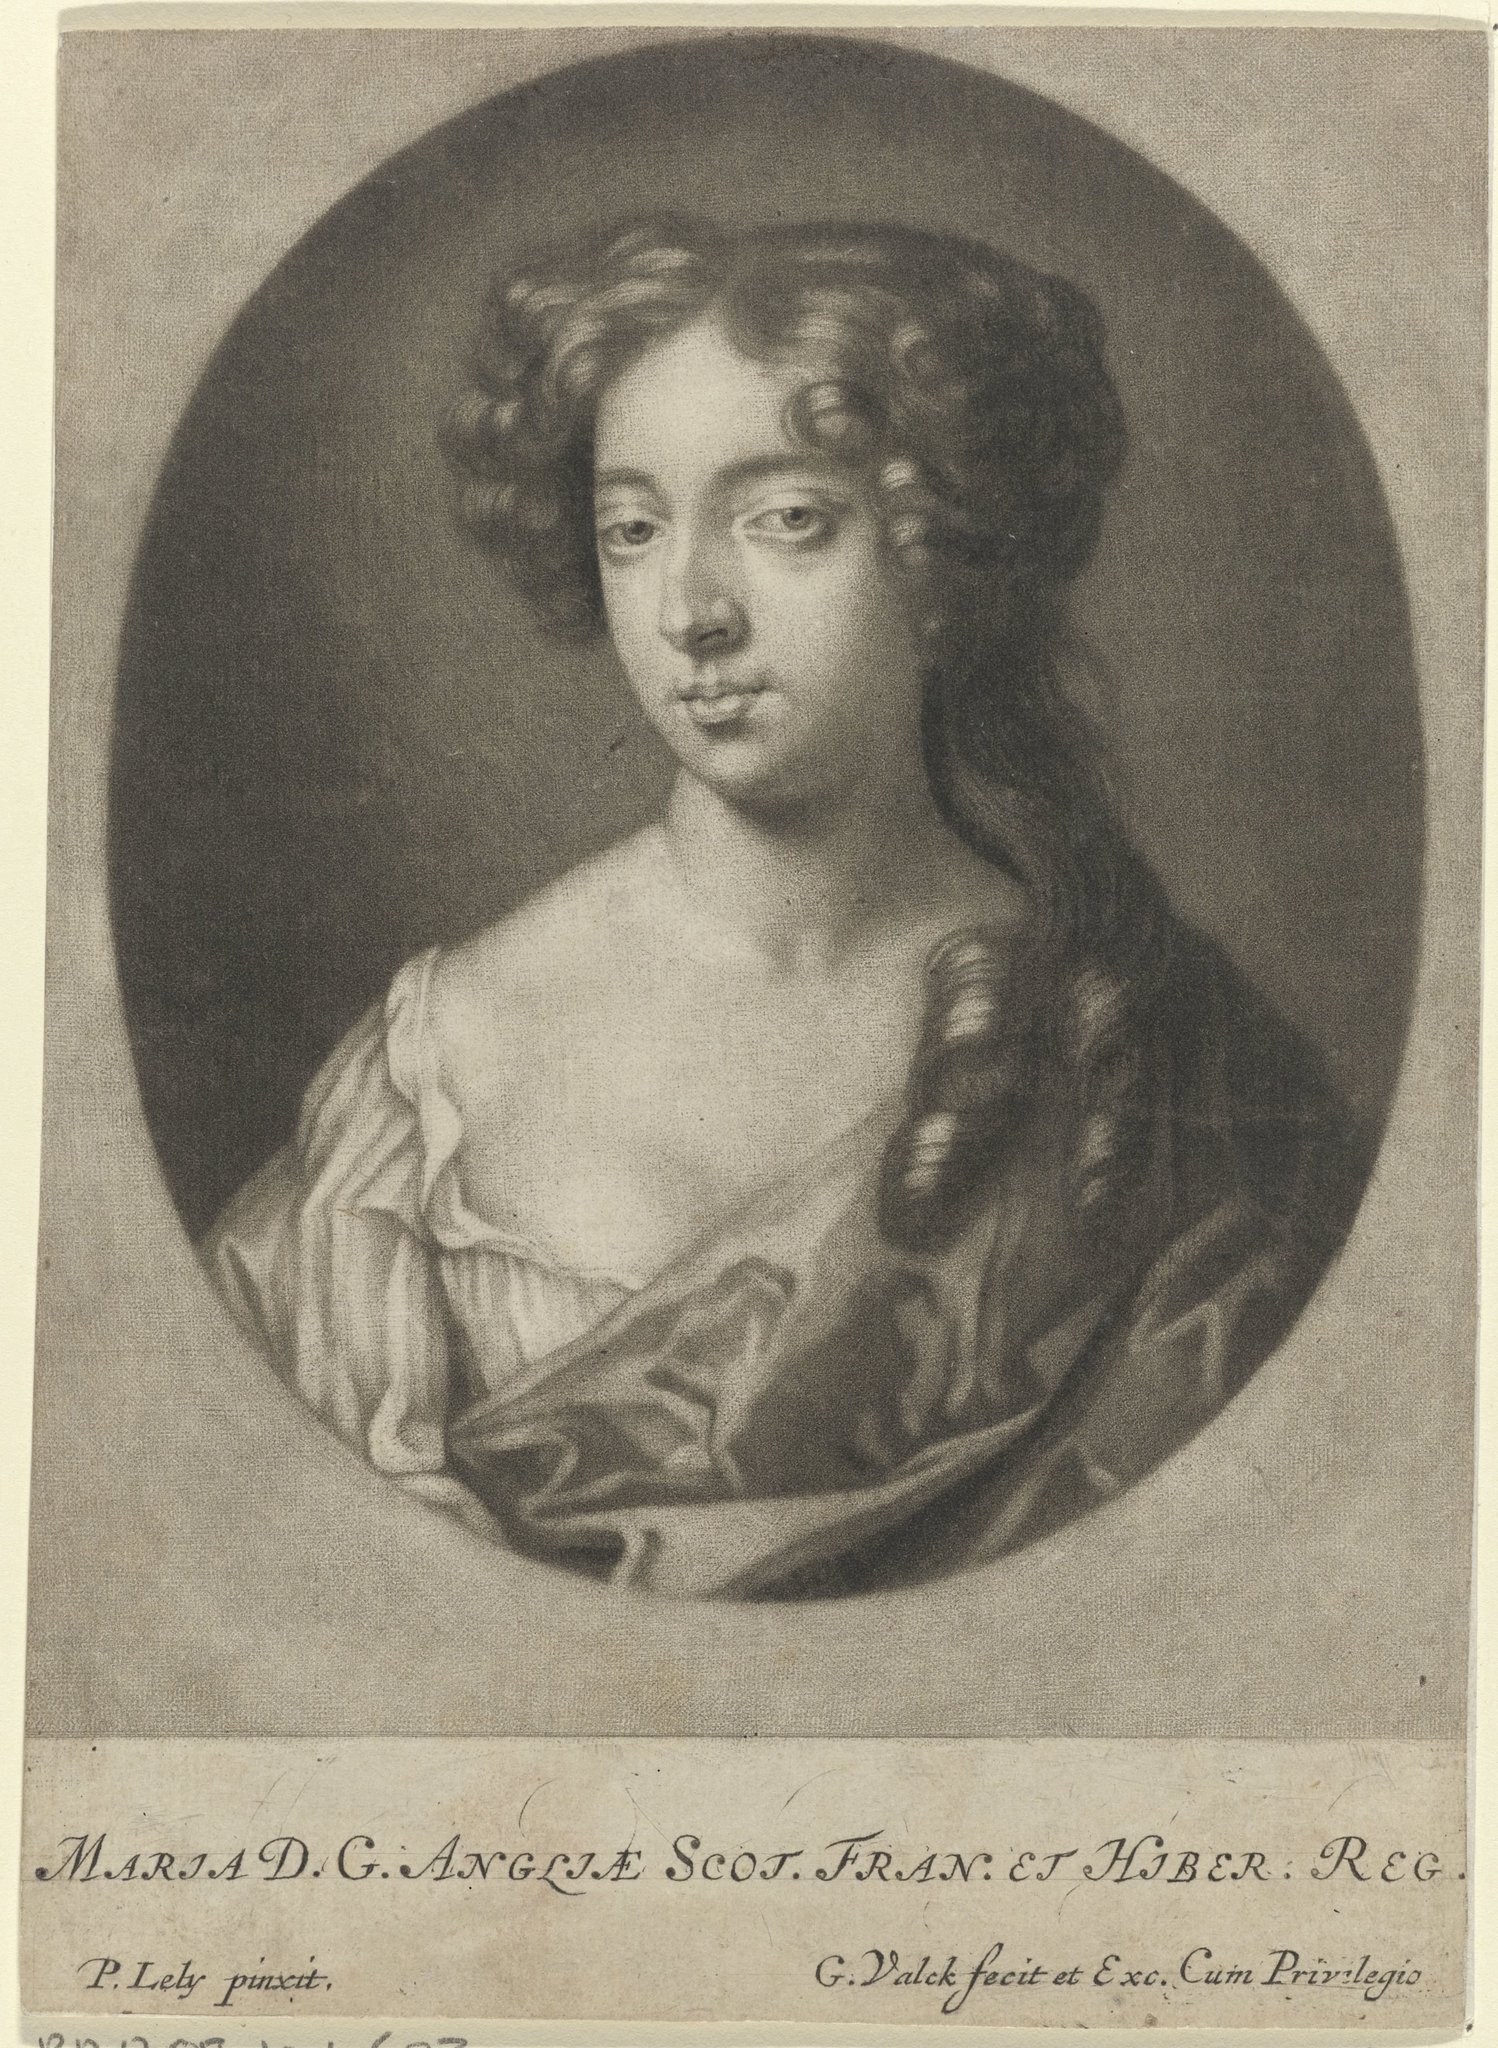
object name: print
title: Portret van Maria II Stuart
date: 1688-1726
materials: paper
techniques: mezzotint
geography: amsterdam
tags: london, maria ii stuart (koningin van engeland, schotland en ierland)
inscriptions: collector's mark: Lugt 2228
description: Portret van Maria II in een ovaal. In de ondermarge haar naam en titels.